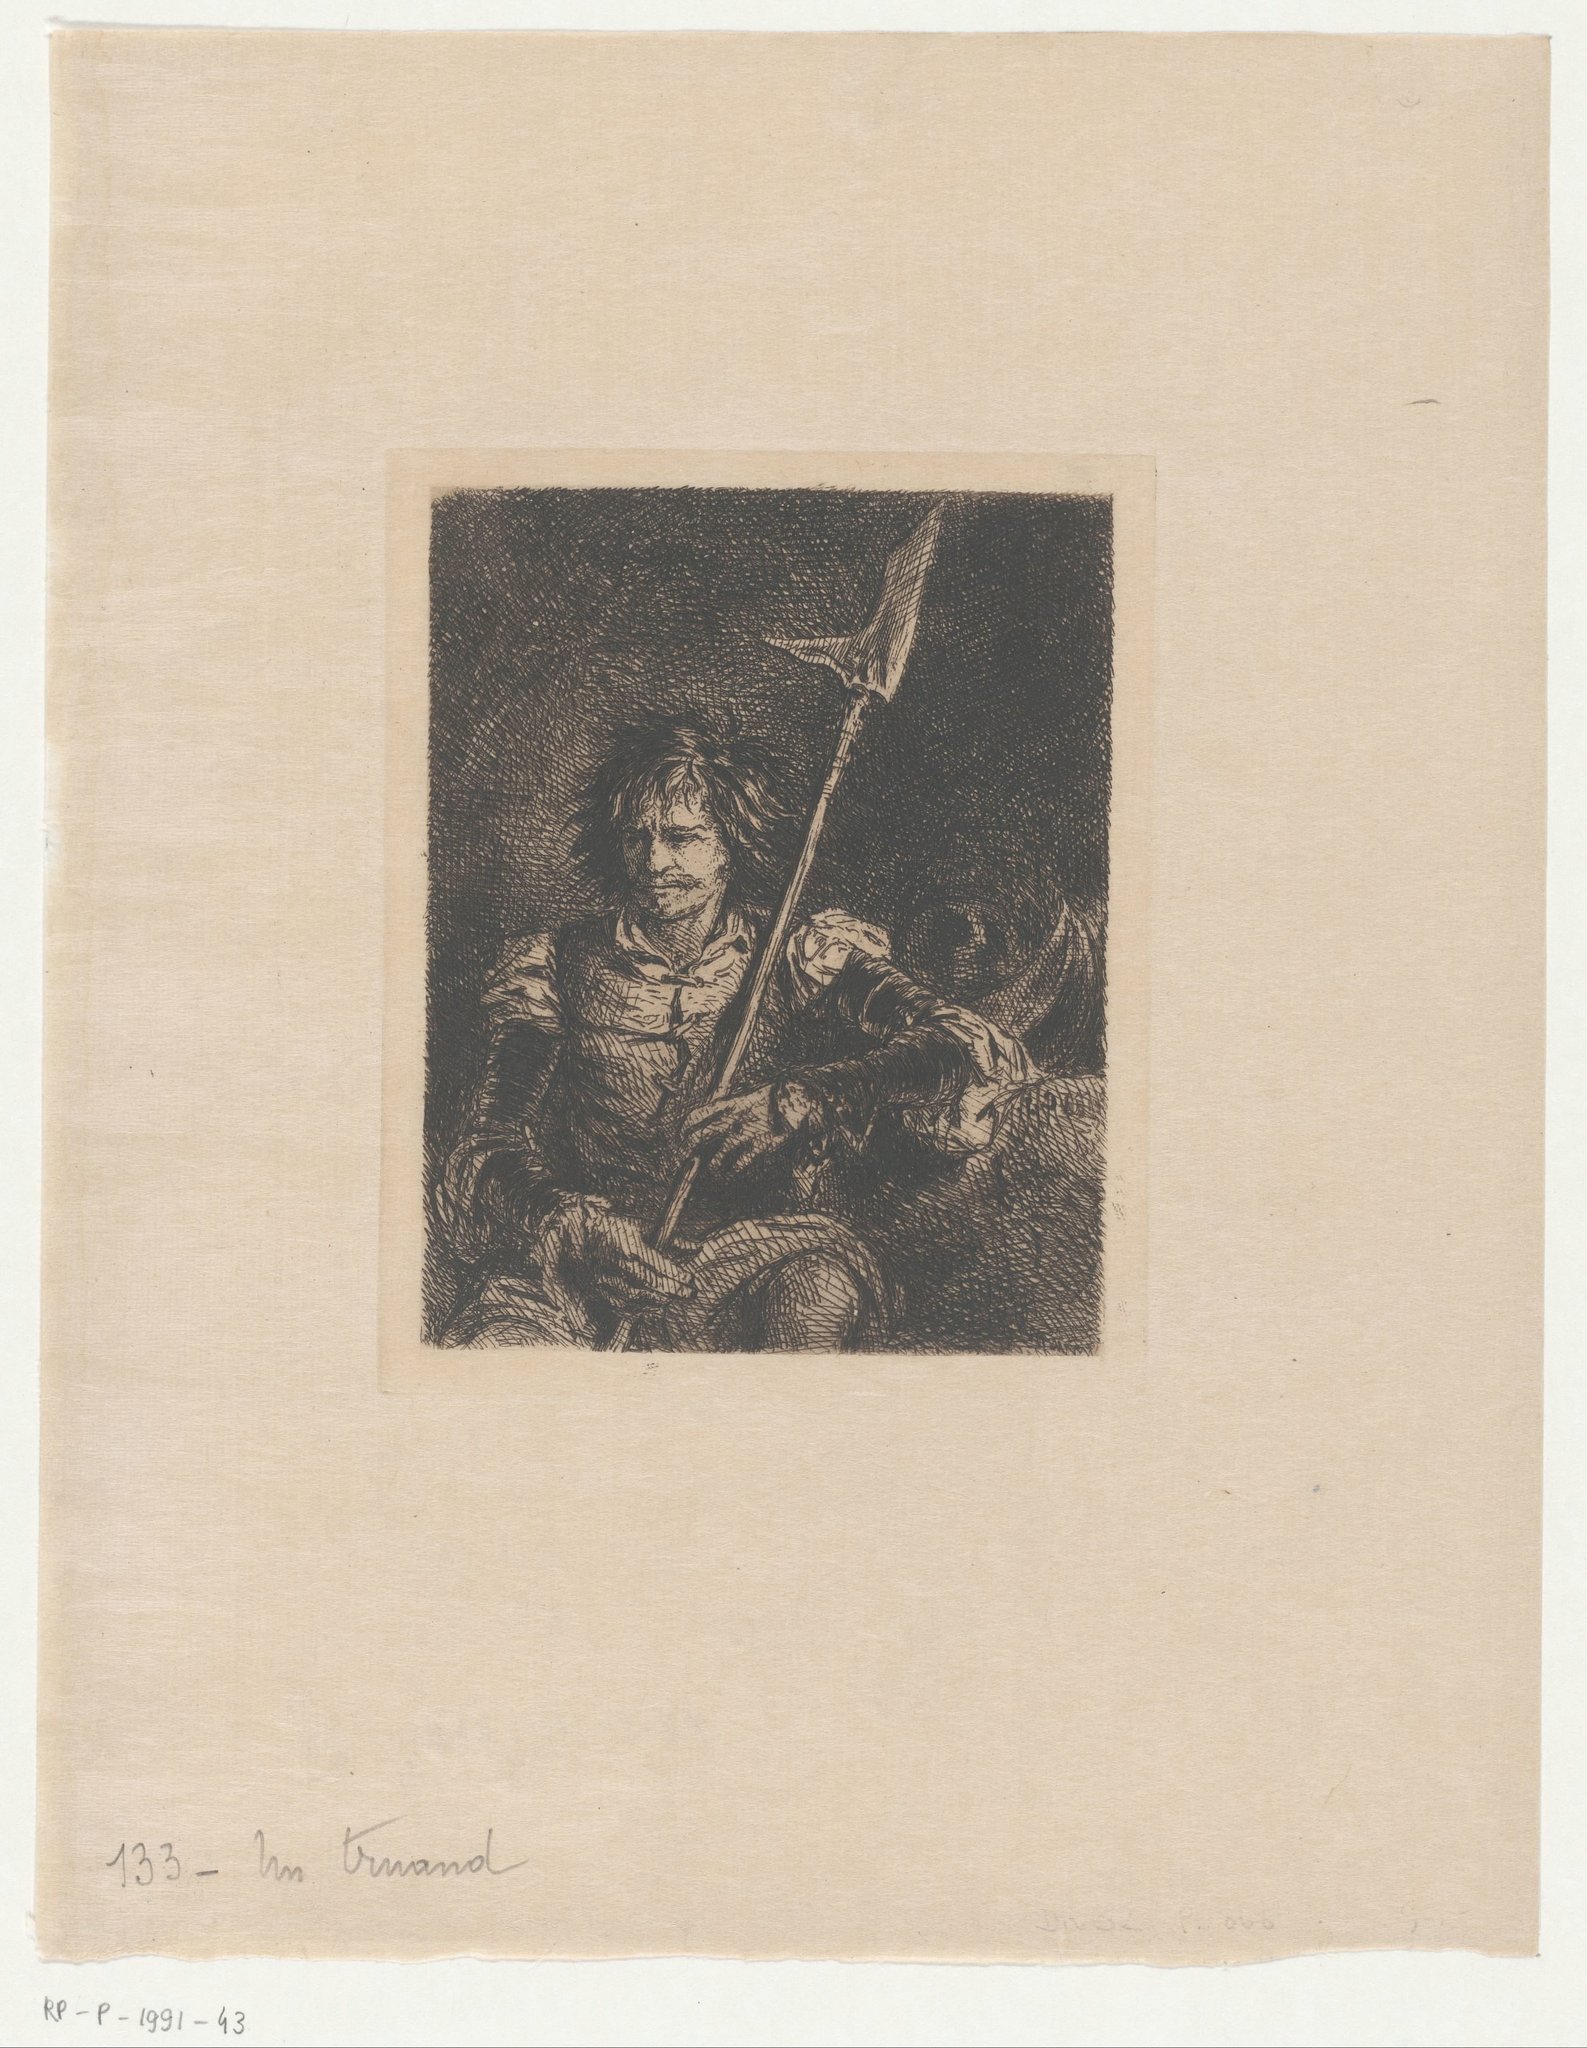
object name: print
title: Zittende hellebaardier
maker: charles emile jacque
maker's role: draughtsman, painter, print maker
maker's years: 1813-1894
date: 1846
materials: paper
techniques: etching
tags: the soldier; the soldier's life, helved weapons, polearms (for striking, hacking, thrusting): halberd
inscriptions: collector's mark: Lugt 2760, inscription: ‘Le Truand’, collector's mark: Lugt 2228